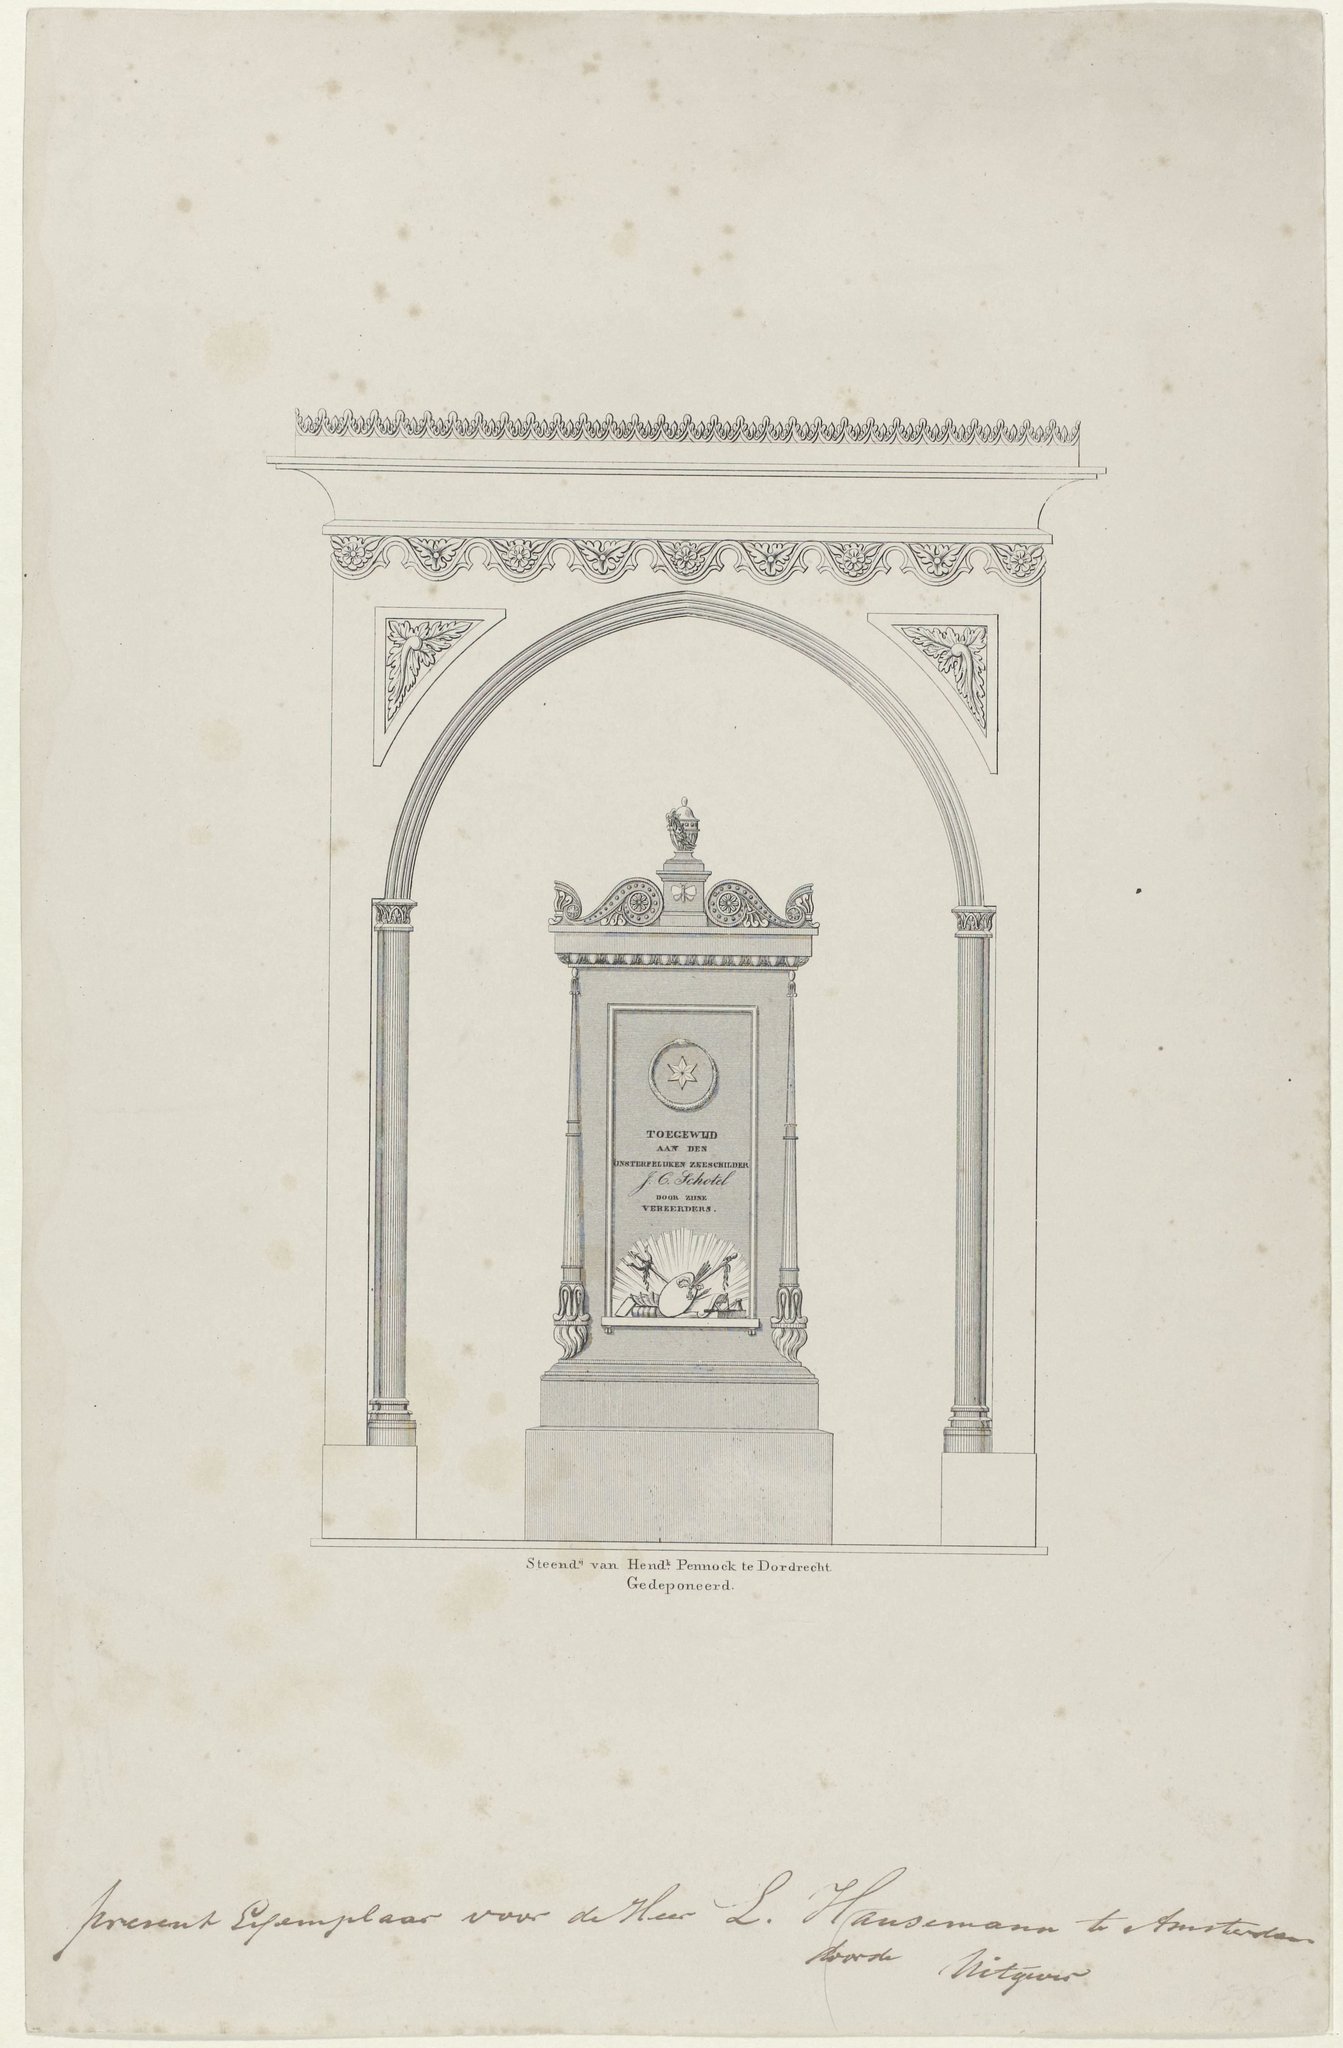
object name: print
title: Monument ter nagedachtenis aan de schilder J.C. Schotel, 1838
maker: hendrikus pennock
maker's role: print maker, printer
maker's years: 1814-1848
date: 1839-1842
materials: paper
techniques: lithograph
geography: dordrecht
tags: dordrecht, draughtsman, johannes christiaan schotel, grave-building, monumental tomb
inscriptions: collector's mark: Lugt 2228, inscription: ‘present Exemplaar voor de Heer L. Hausemann te Amsterdam door de uitgever’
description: Bouwkundige afbeelding van het monument opgericht in de Grote Kerk te Dordrecht ter nagedachtenis aan de zeeschilder Johannes Christiaan Schotel, overleden op 21 december 1838.